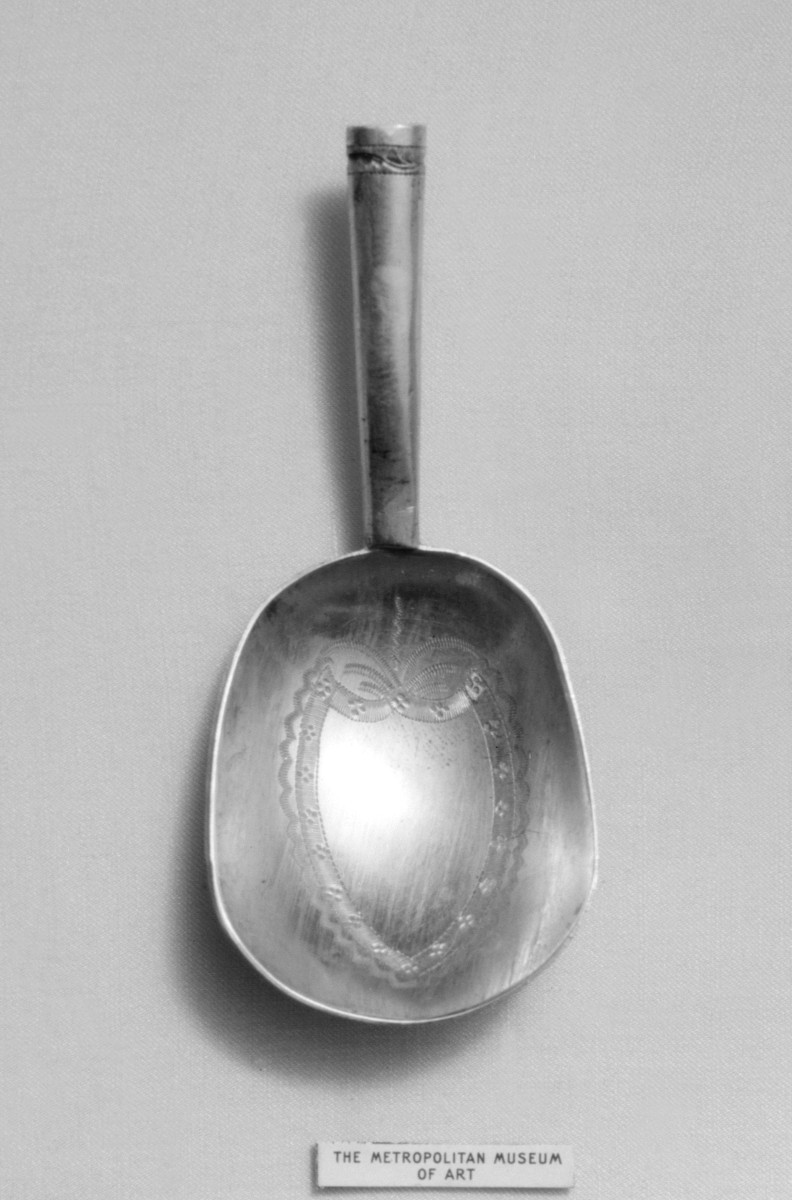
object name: caddy spoon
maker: joseph taylor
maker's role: maker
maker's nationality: british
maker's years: 1767-1827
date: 1804-1805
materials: silver